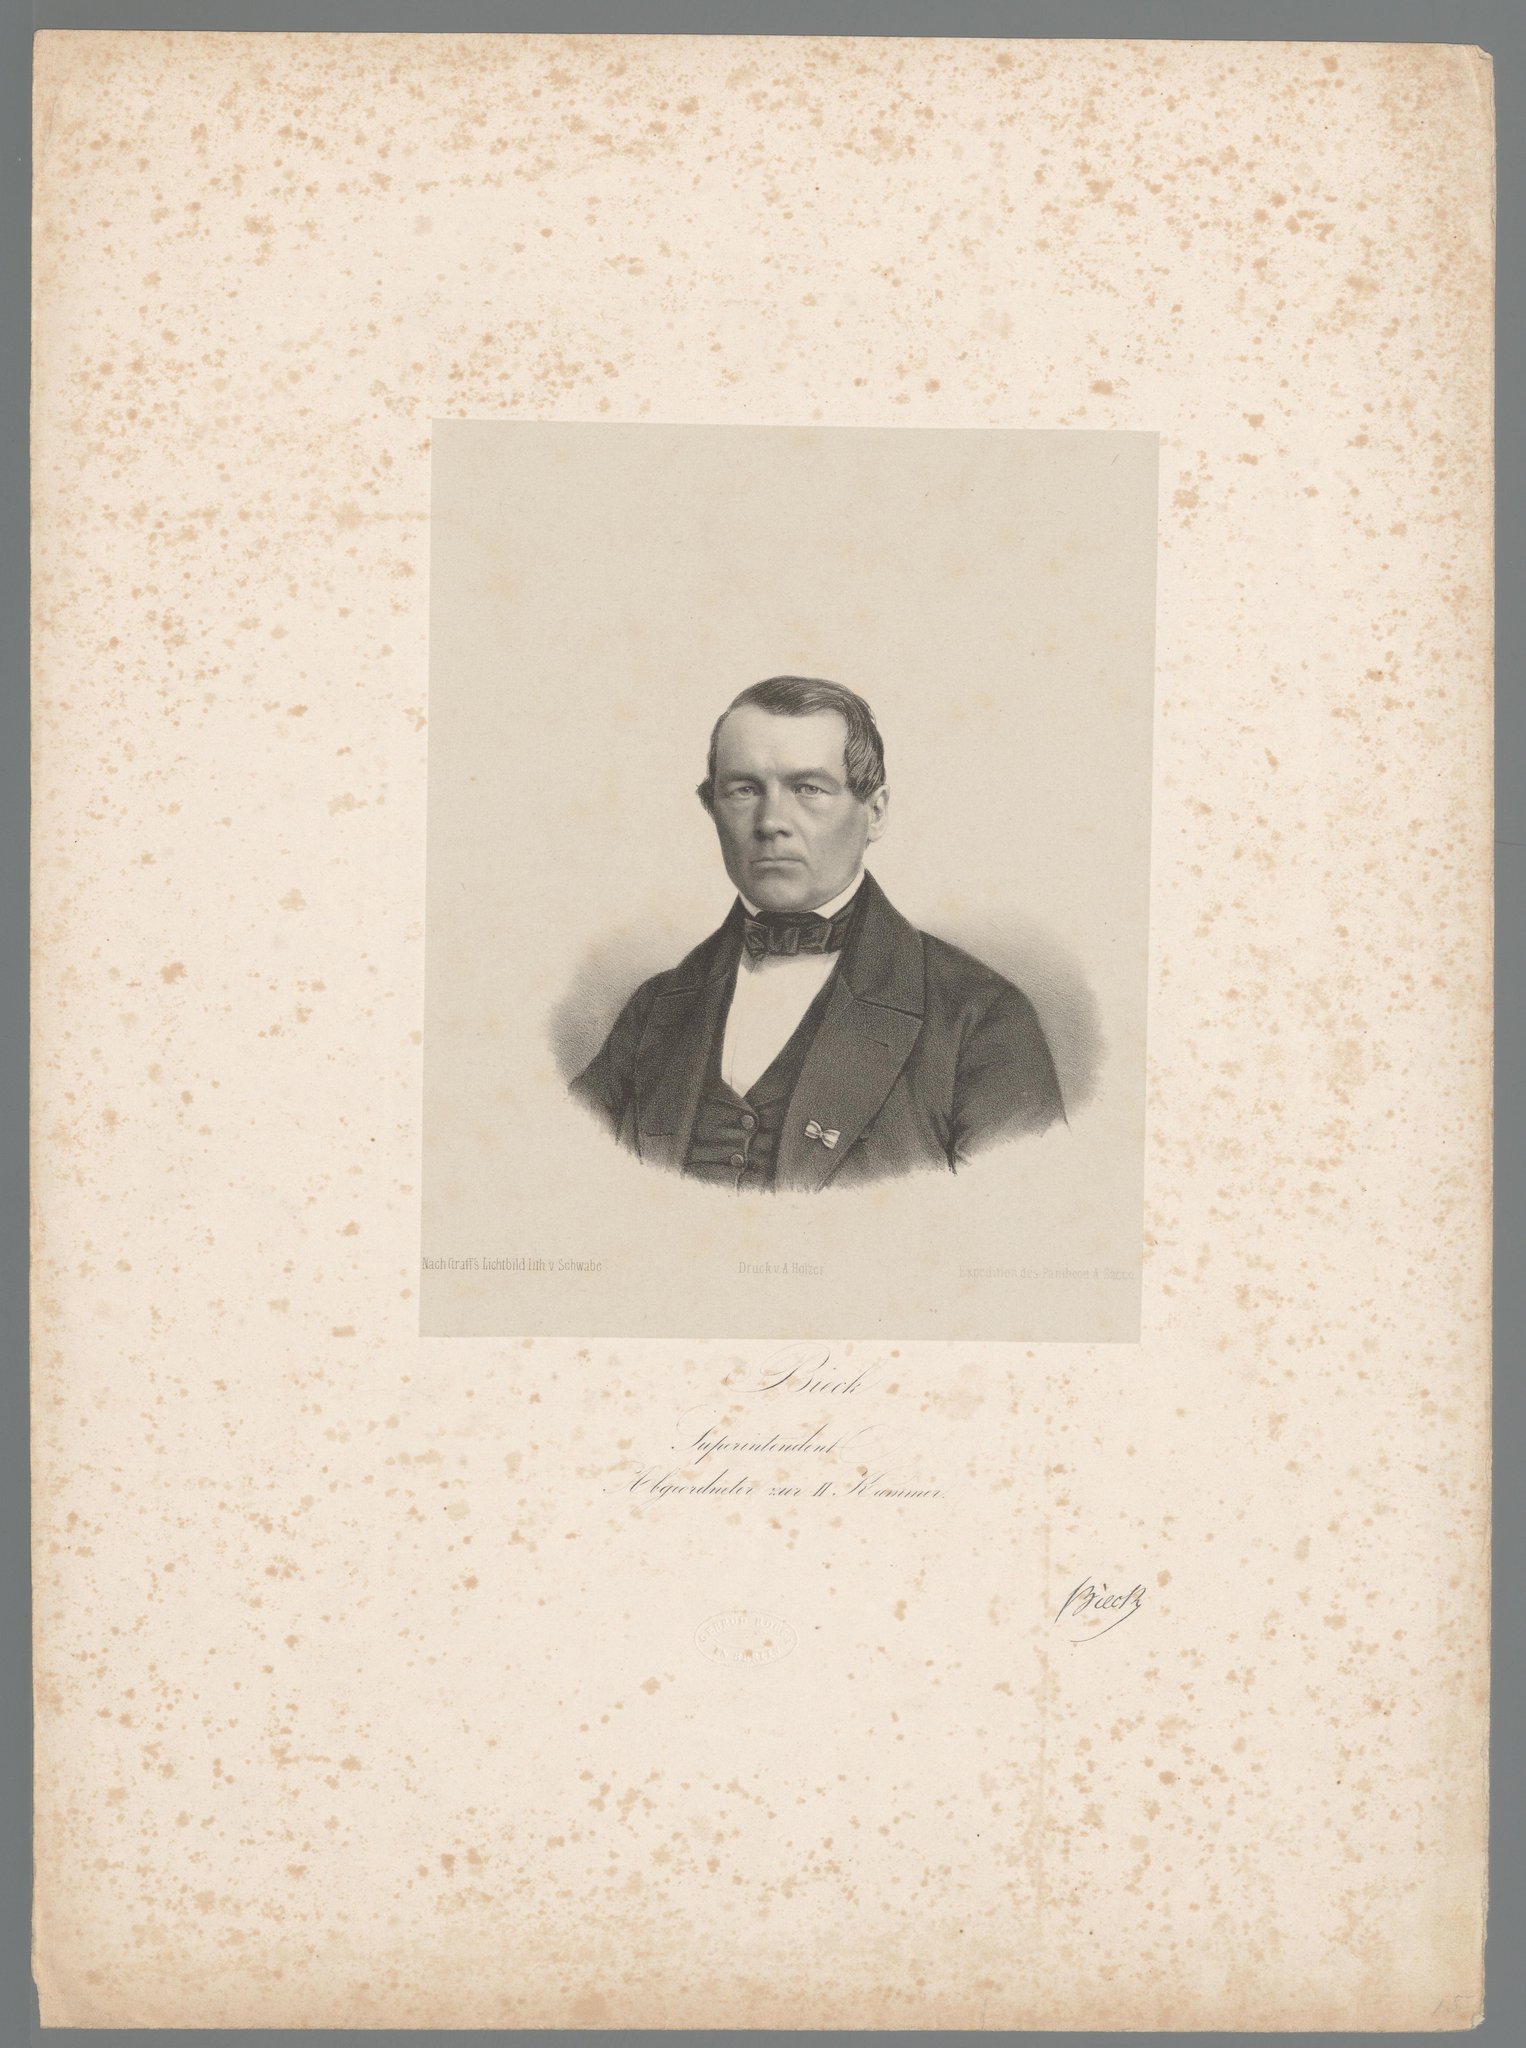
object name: print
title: Bieck, Superintendent, Abgeordneter zur II Kammer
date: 1830-1860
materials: paper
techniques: lithograph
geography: berlin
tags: adult man, historical persons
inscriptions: check stamp: Lugt 2141c, collector's mark: Lugt 2228